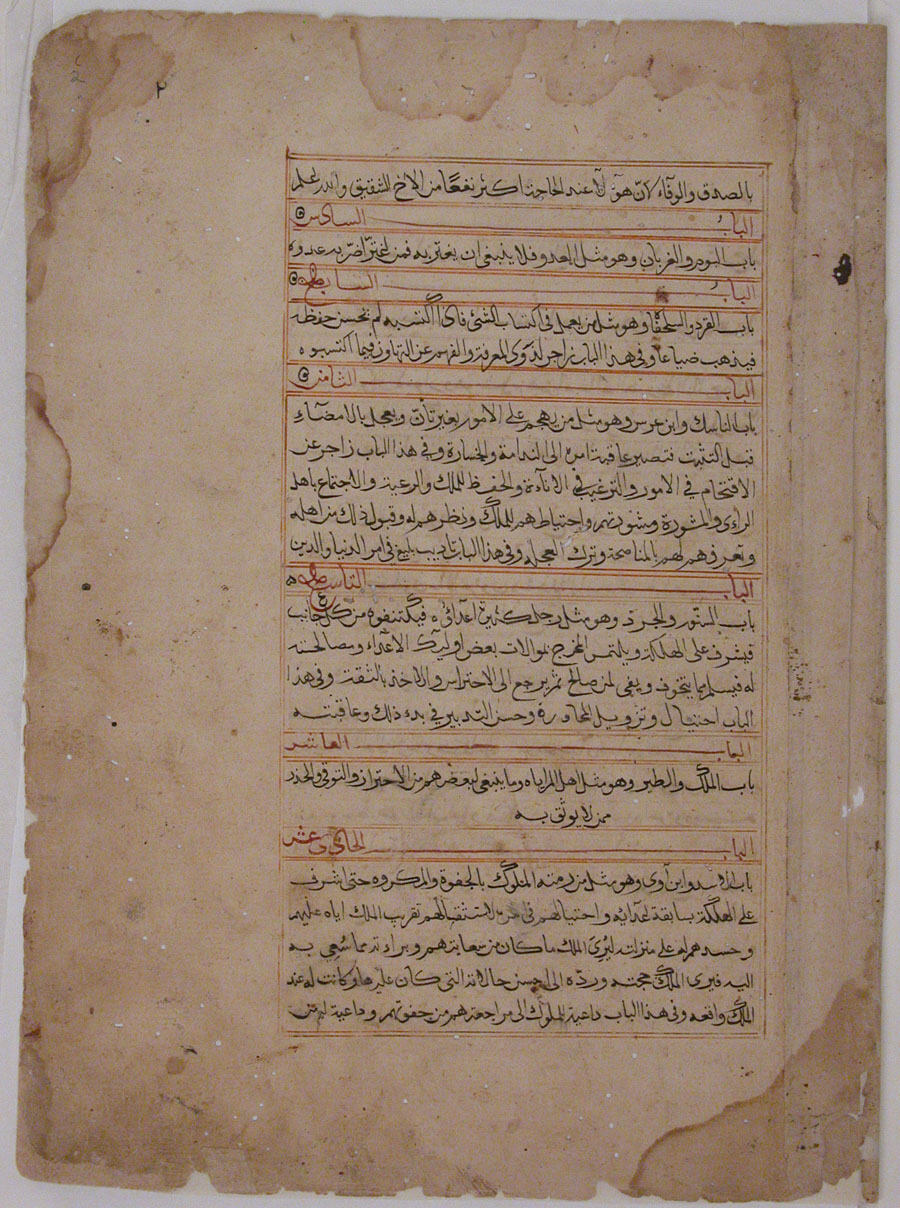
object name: folio from an illustrated manuscript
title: Page of Calligraphy from a Kalila wa Dimna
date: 1526-1550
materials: ink, paper, watercolor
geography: india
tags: arabic,calligraphy